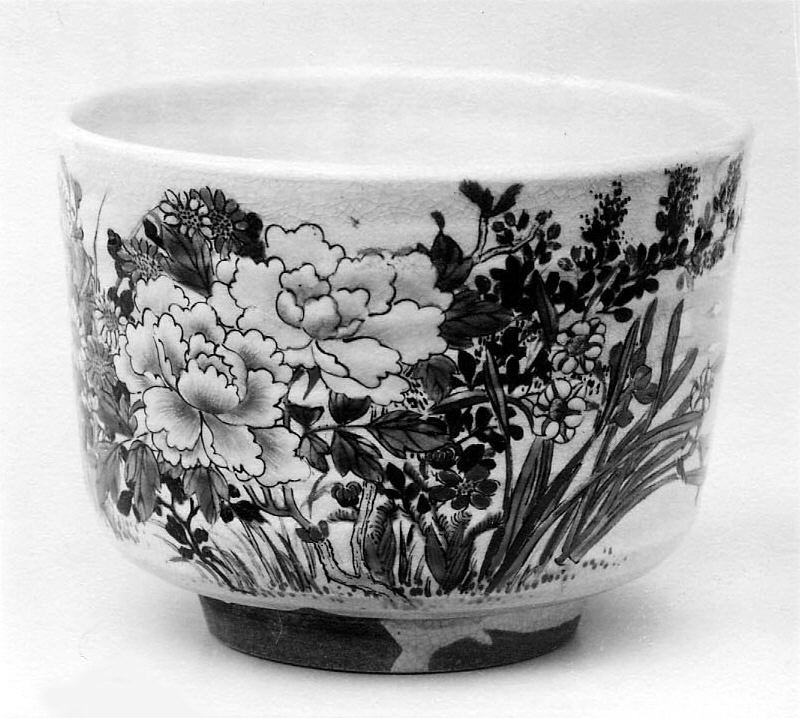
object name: teabowl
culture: japanese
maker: minpei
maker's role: artist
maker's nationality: japanese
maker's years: 19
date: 1830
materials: enamel, glaze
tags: leaves